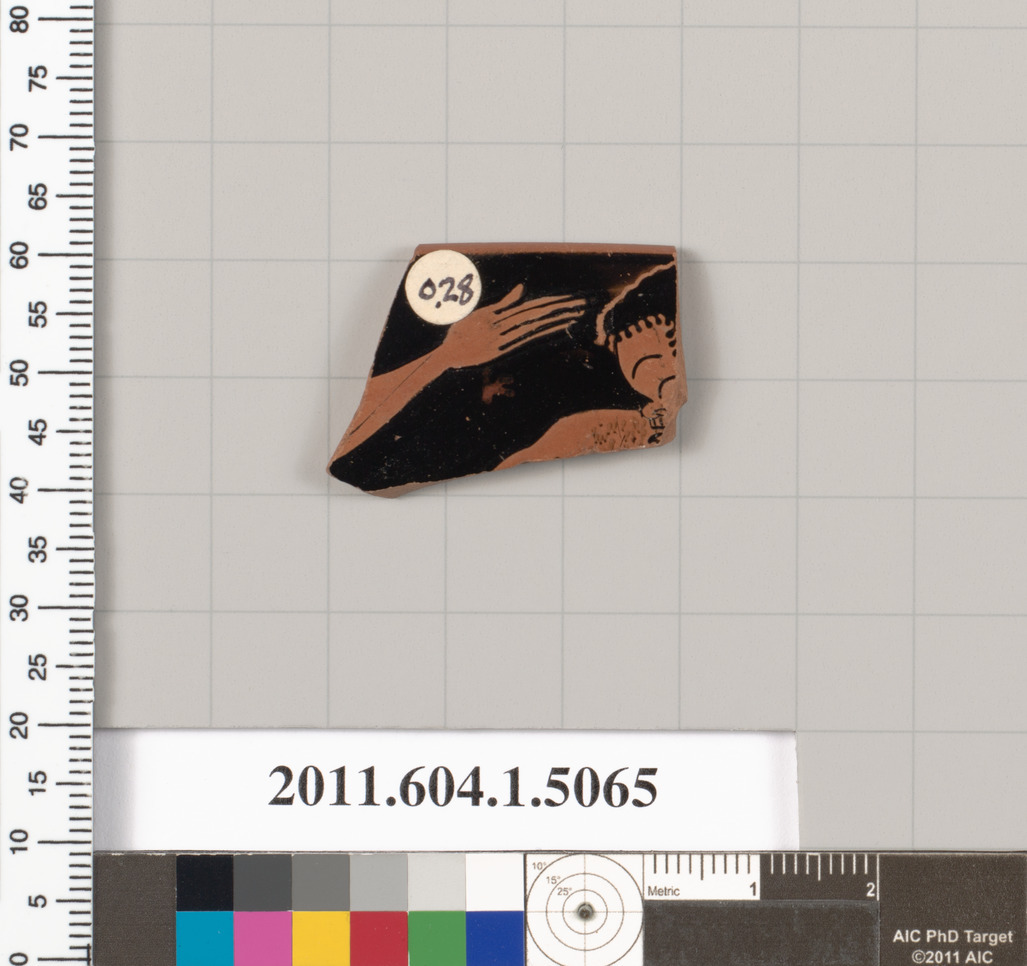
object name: kylix fragment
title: Terracotta rim fragment of a kylix (drinking cup)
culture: greek, attic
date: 520-500 BCE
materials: terracotta